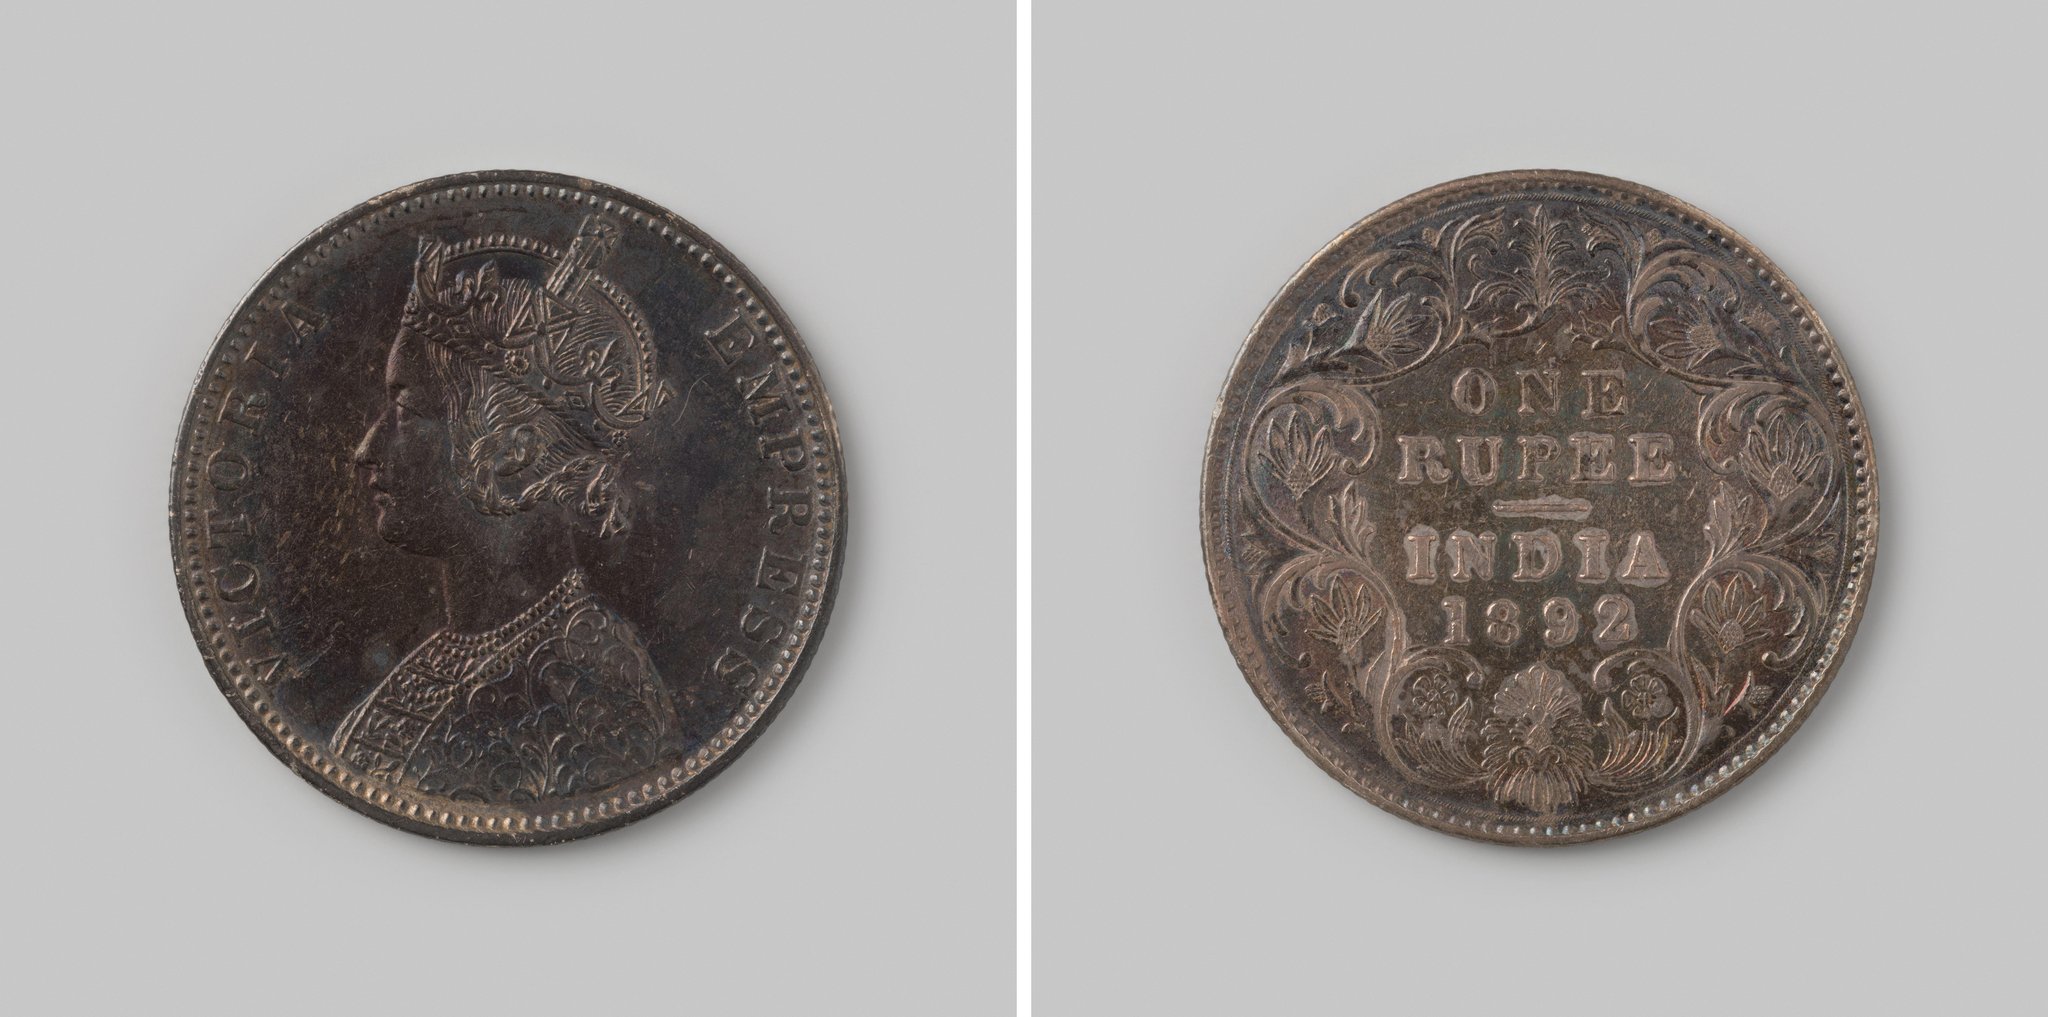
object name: coin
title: India, keizerin Victoria, roepie, 1892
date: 1892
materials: silver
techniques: striking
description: Zilveren munt. Voorzijde: gekroond borstbeeld van keizerin Victoria naar links. Keerzijde: binnen een kring van lotusbloemen in twee regels waarde-aanduiding: one rupee, waaronder lands-aanduiding. Daaronder jaartal. Kartelrand.